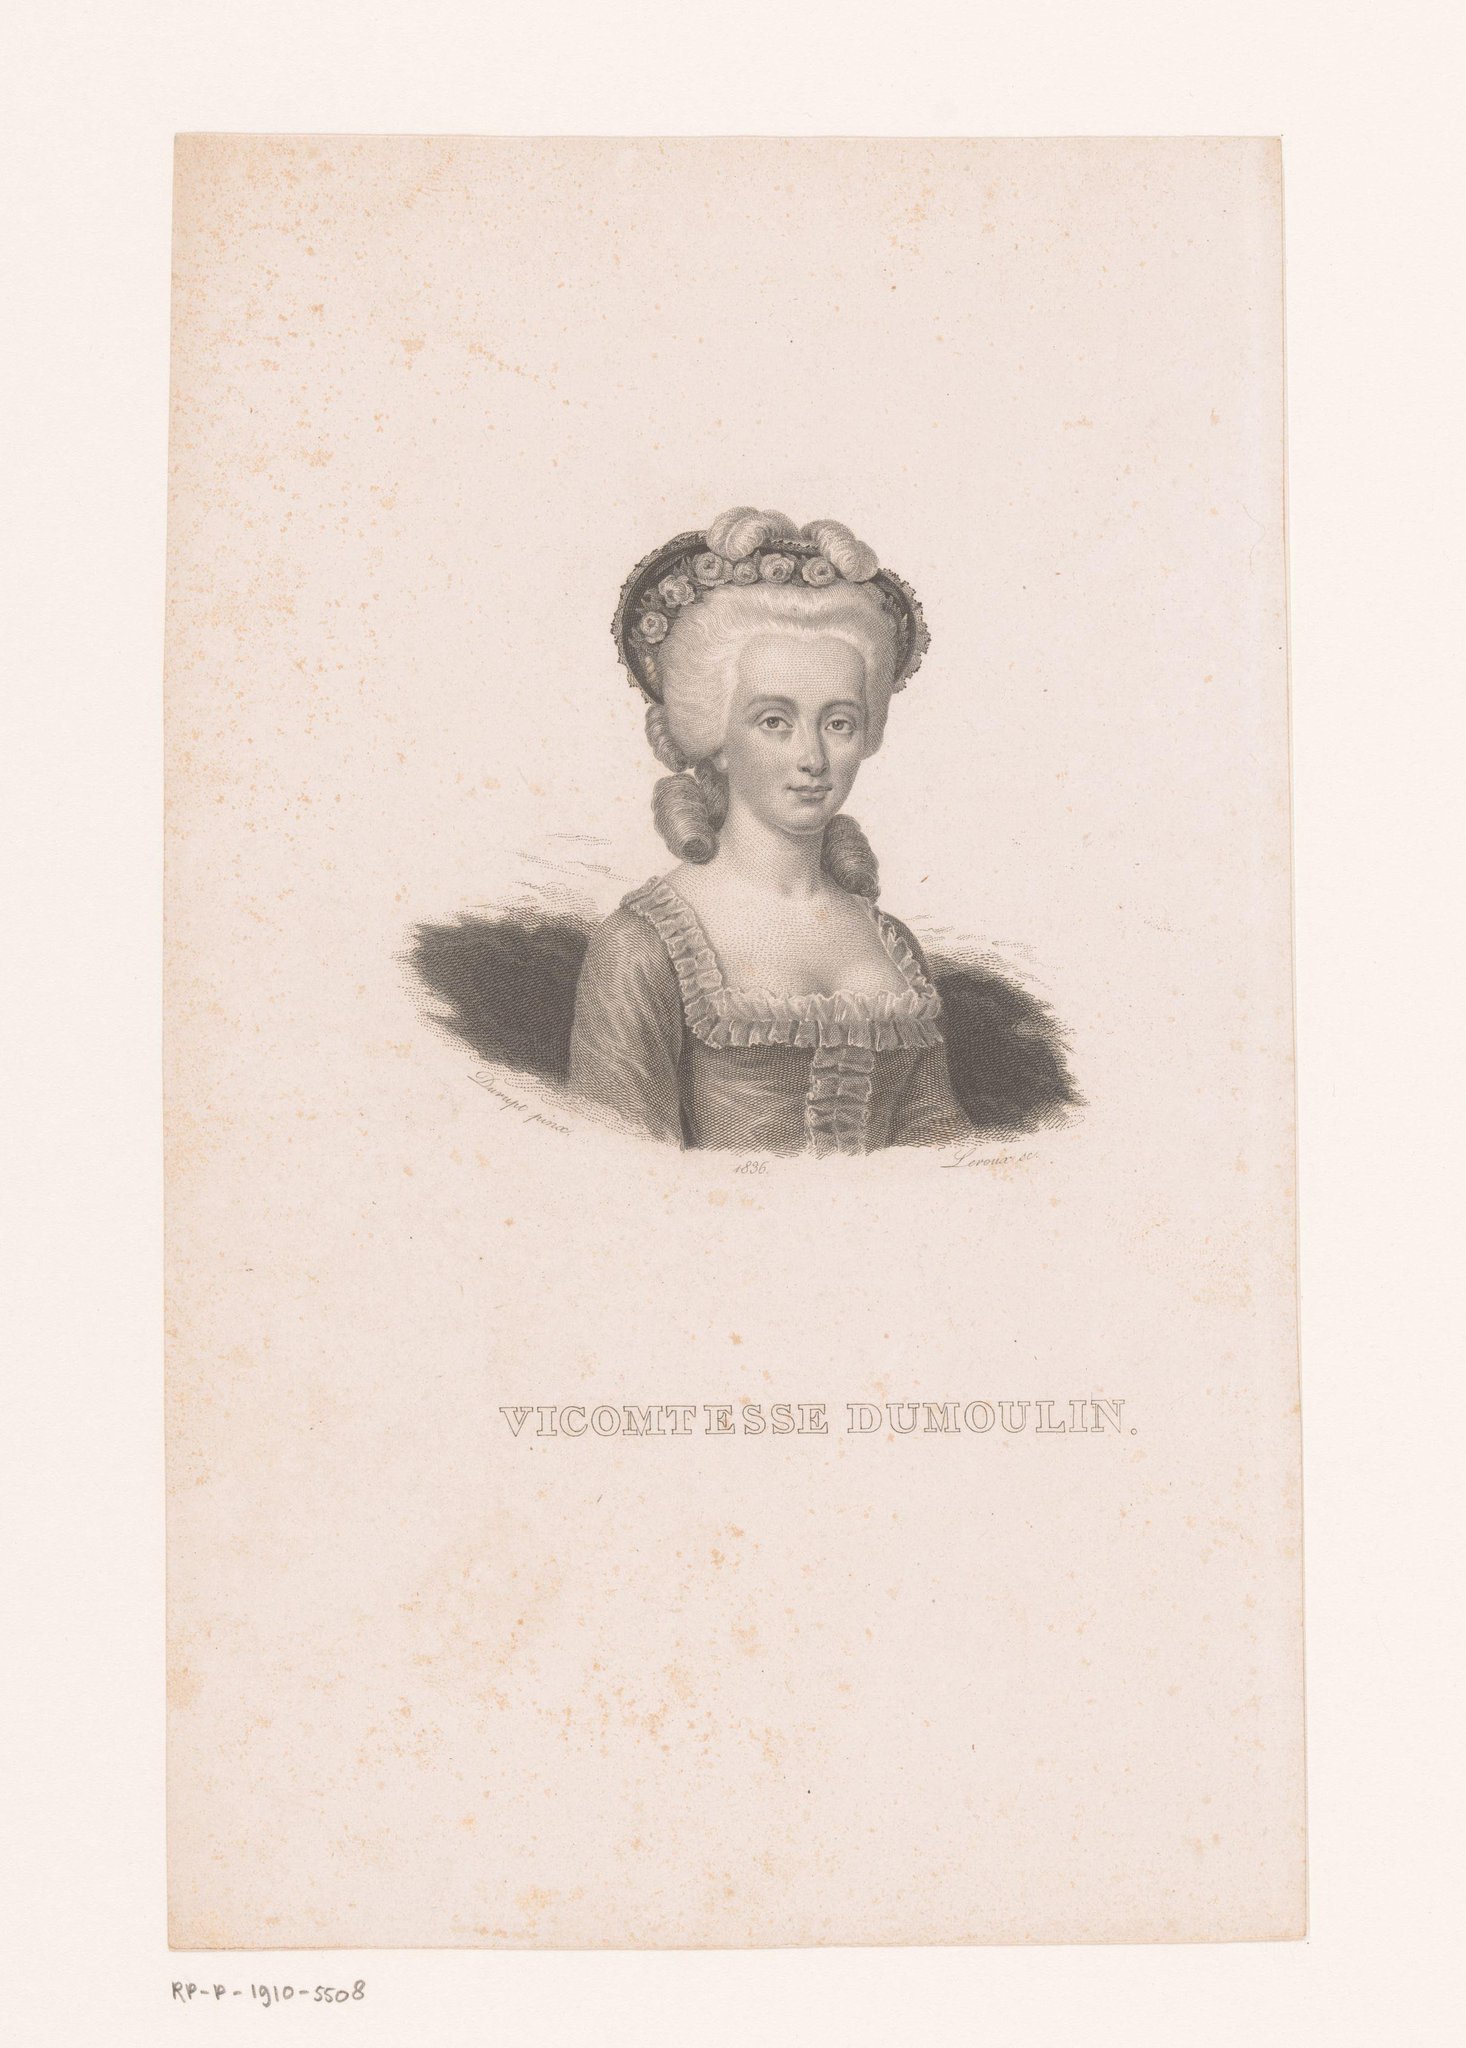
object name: print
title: Portret van de Vicomtesse Dumoulin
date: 1836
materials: paper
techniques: engraving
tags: historical persons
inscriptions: collector's mark: Lugt 2228